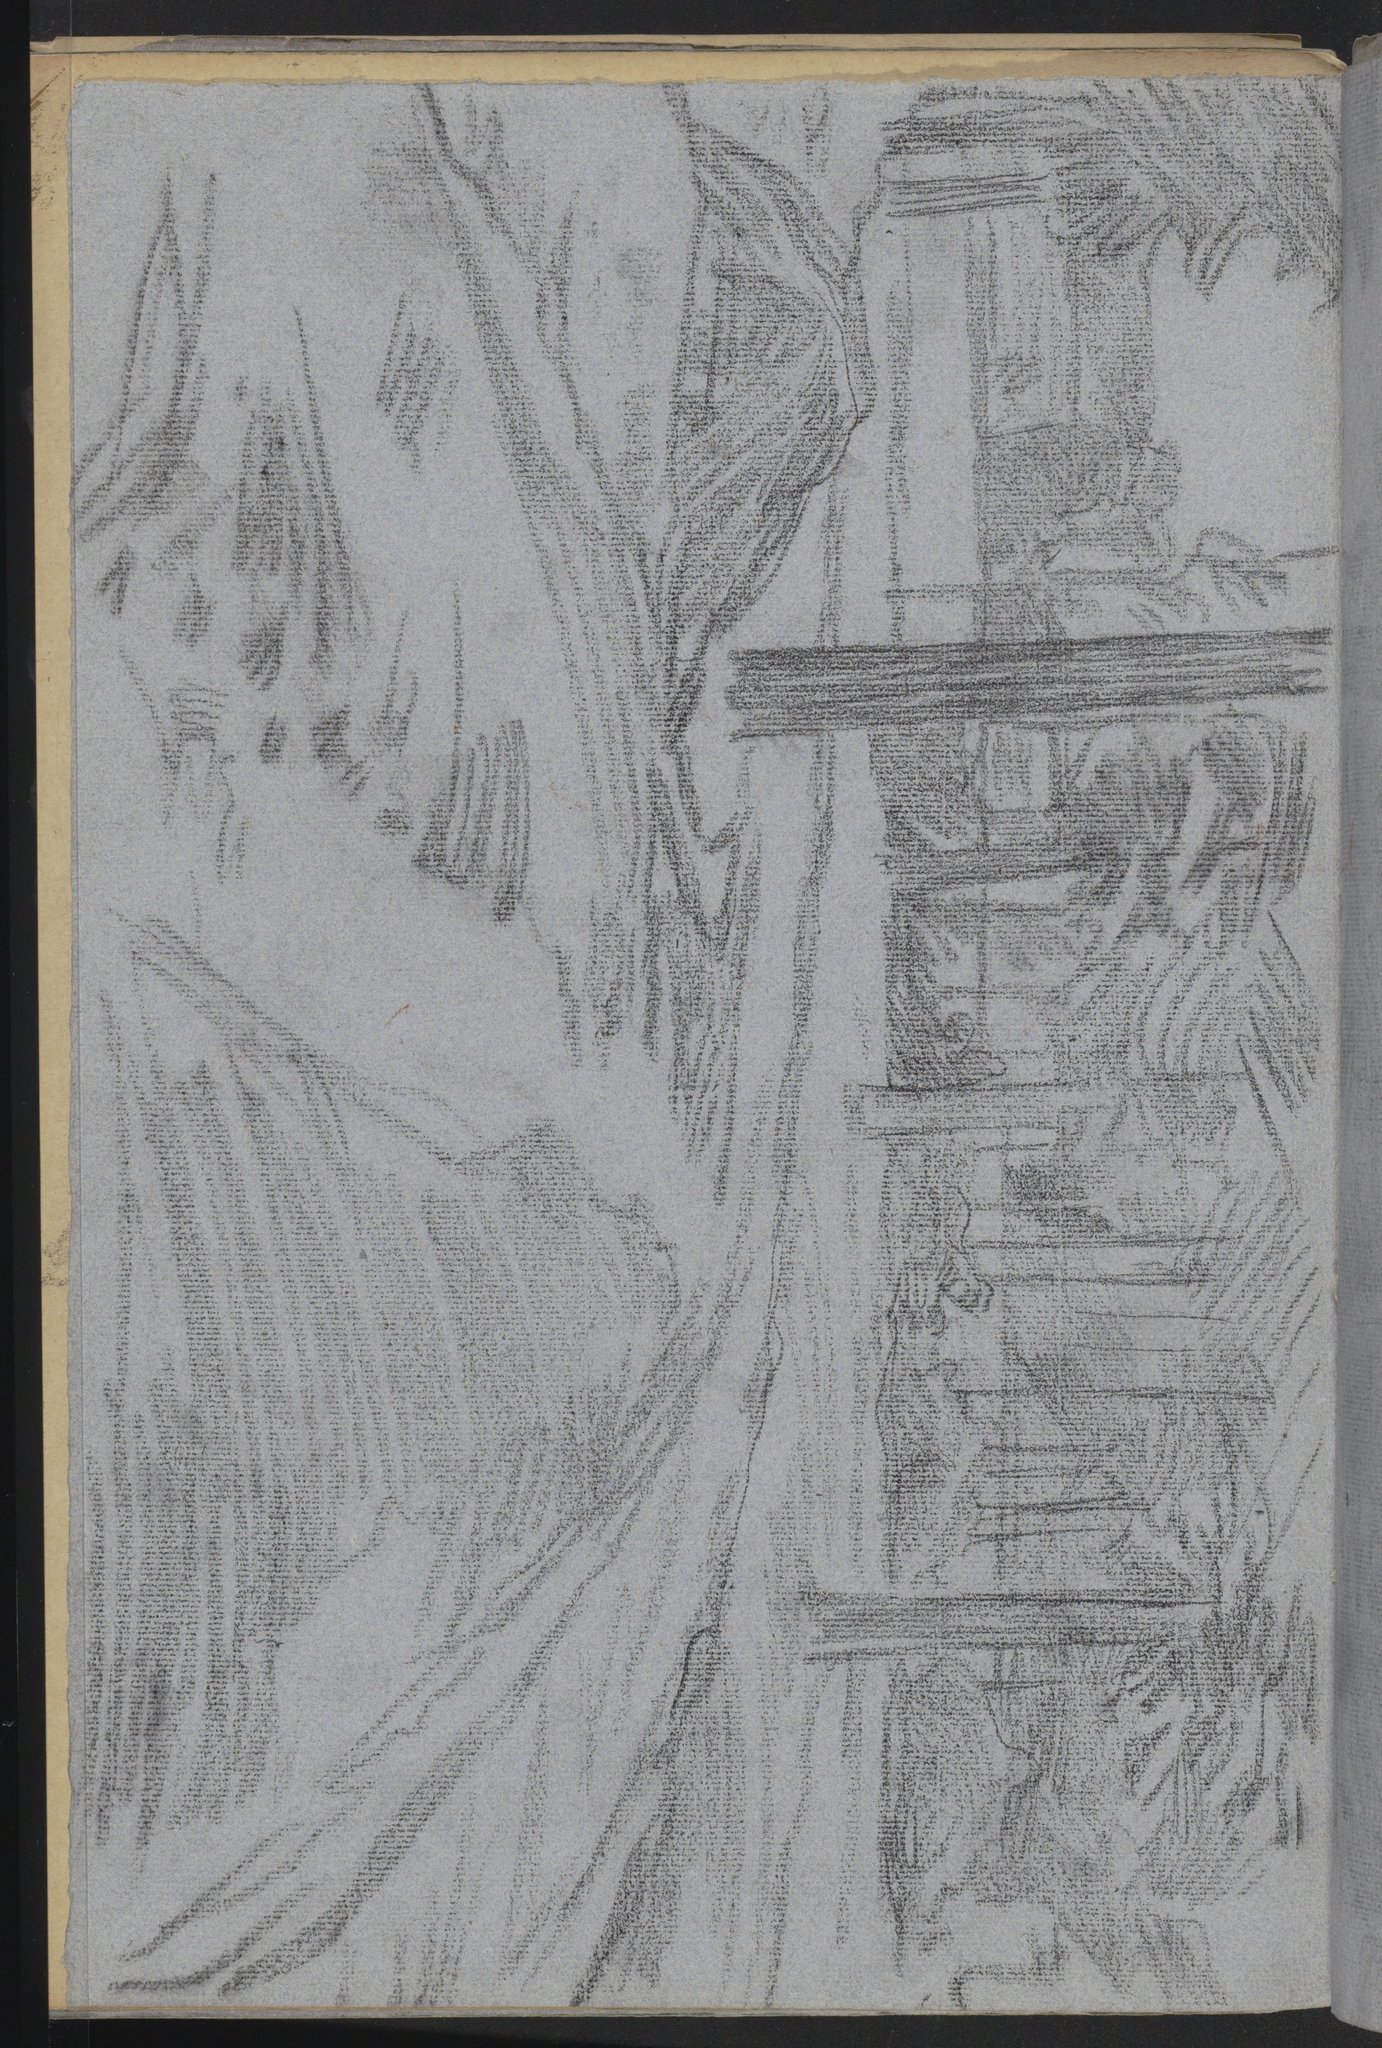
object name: sketchbook leaf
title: Pad in een boomrijk vlak landschap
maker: jan veth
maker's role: designer, draughtsman, painter, print maker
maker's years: 1864-1925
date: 1874-1925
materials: chalk, paper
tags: trees, landscapes, road, path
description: Blad 39 verso uit een schetsboek met 42 bladen.